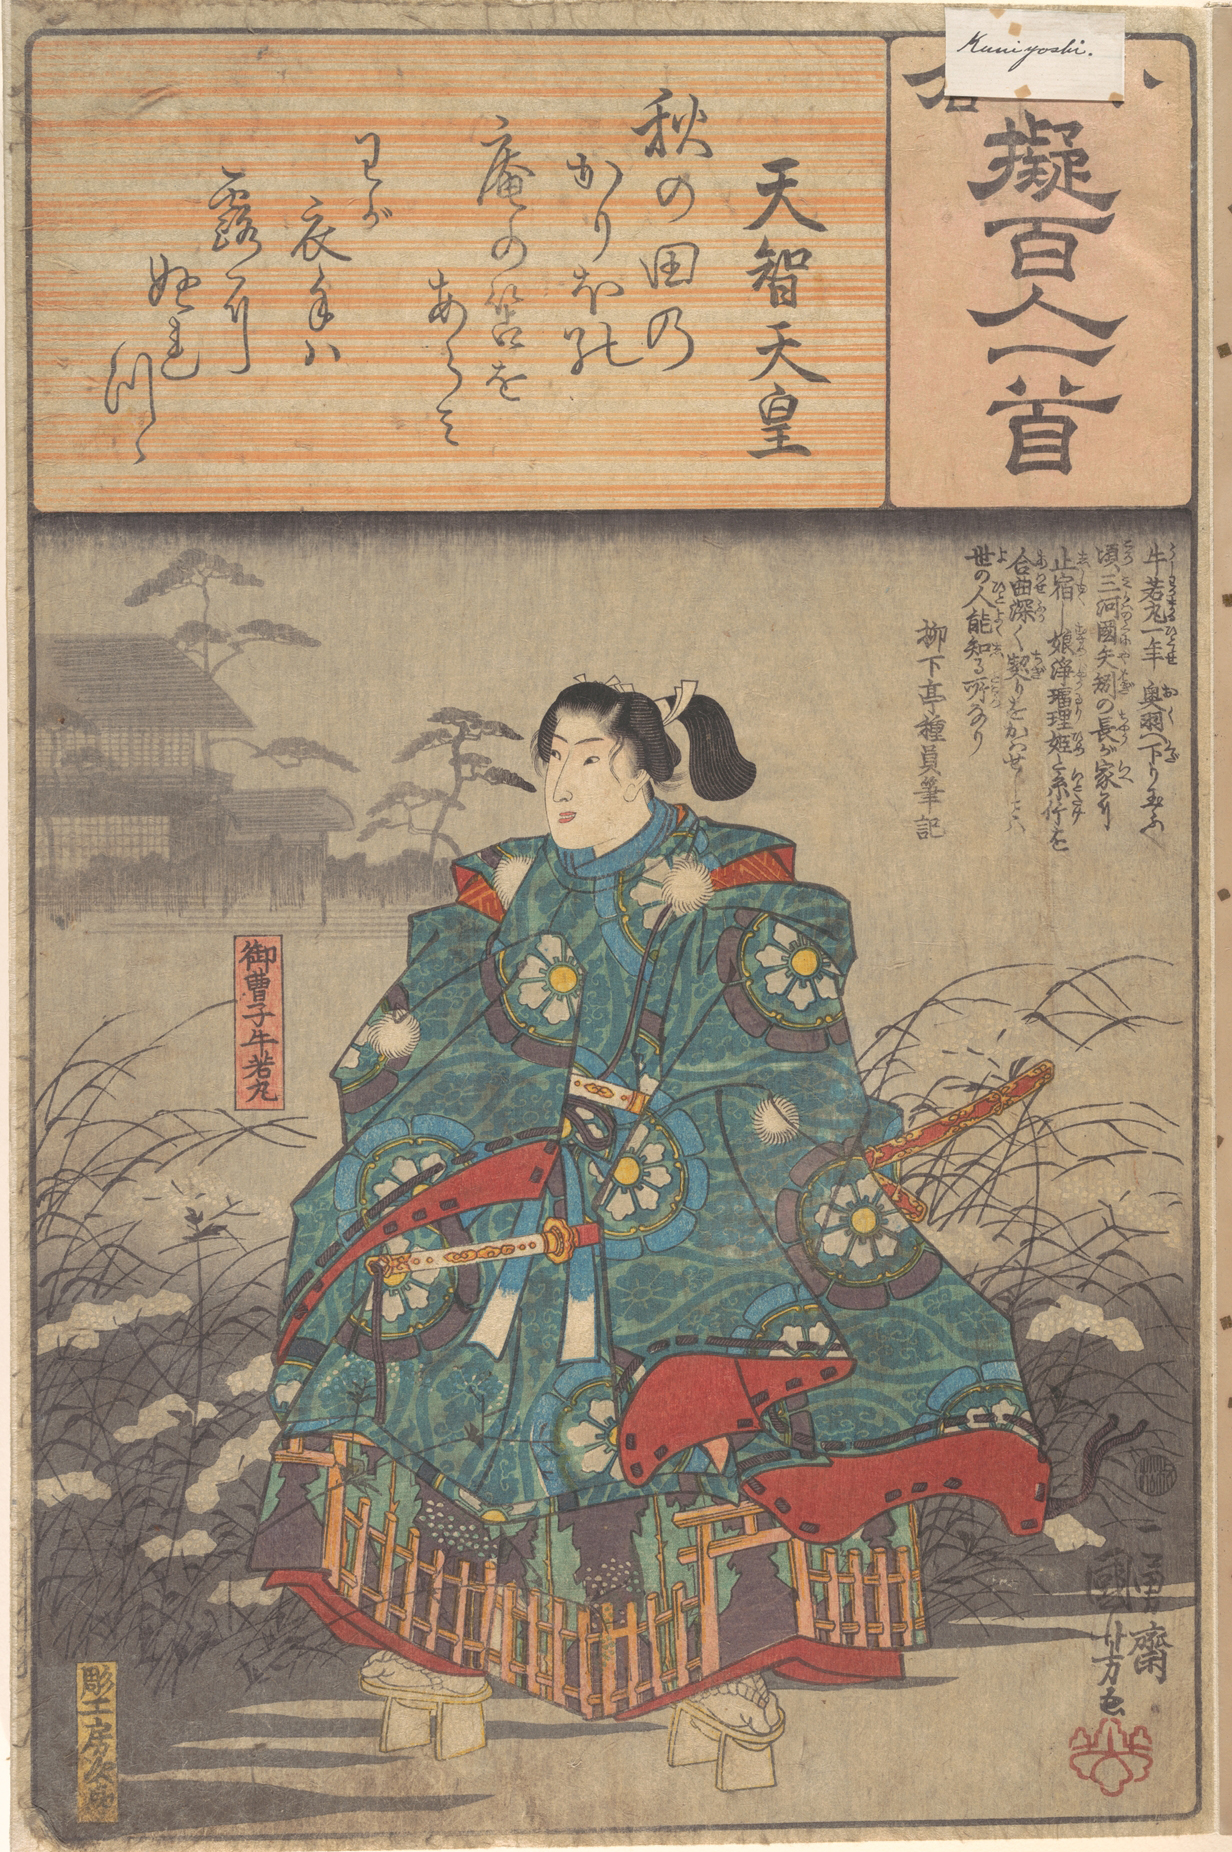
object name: print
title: Album of Eighty-eight Prints from the series Ogura Imitations of One Hundred Poems by One Hundred Poets (Ogura nazorae hyakunin isshu)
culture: japanese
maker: utagawa hiroshige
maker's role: artist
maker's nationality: japanese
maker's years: 1797-1858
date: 1845-1848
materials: ink, paper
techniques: woodblock print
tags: human figures,swords